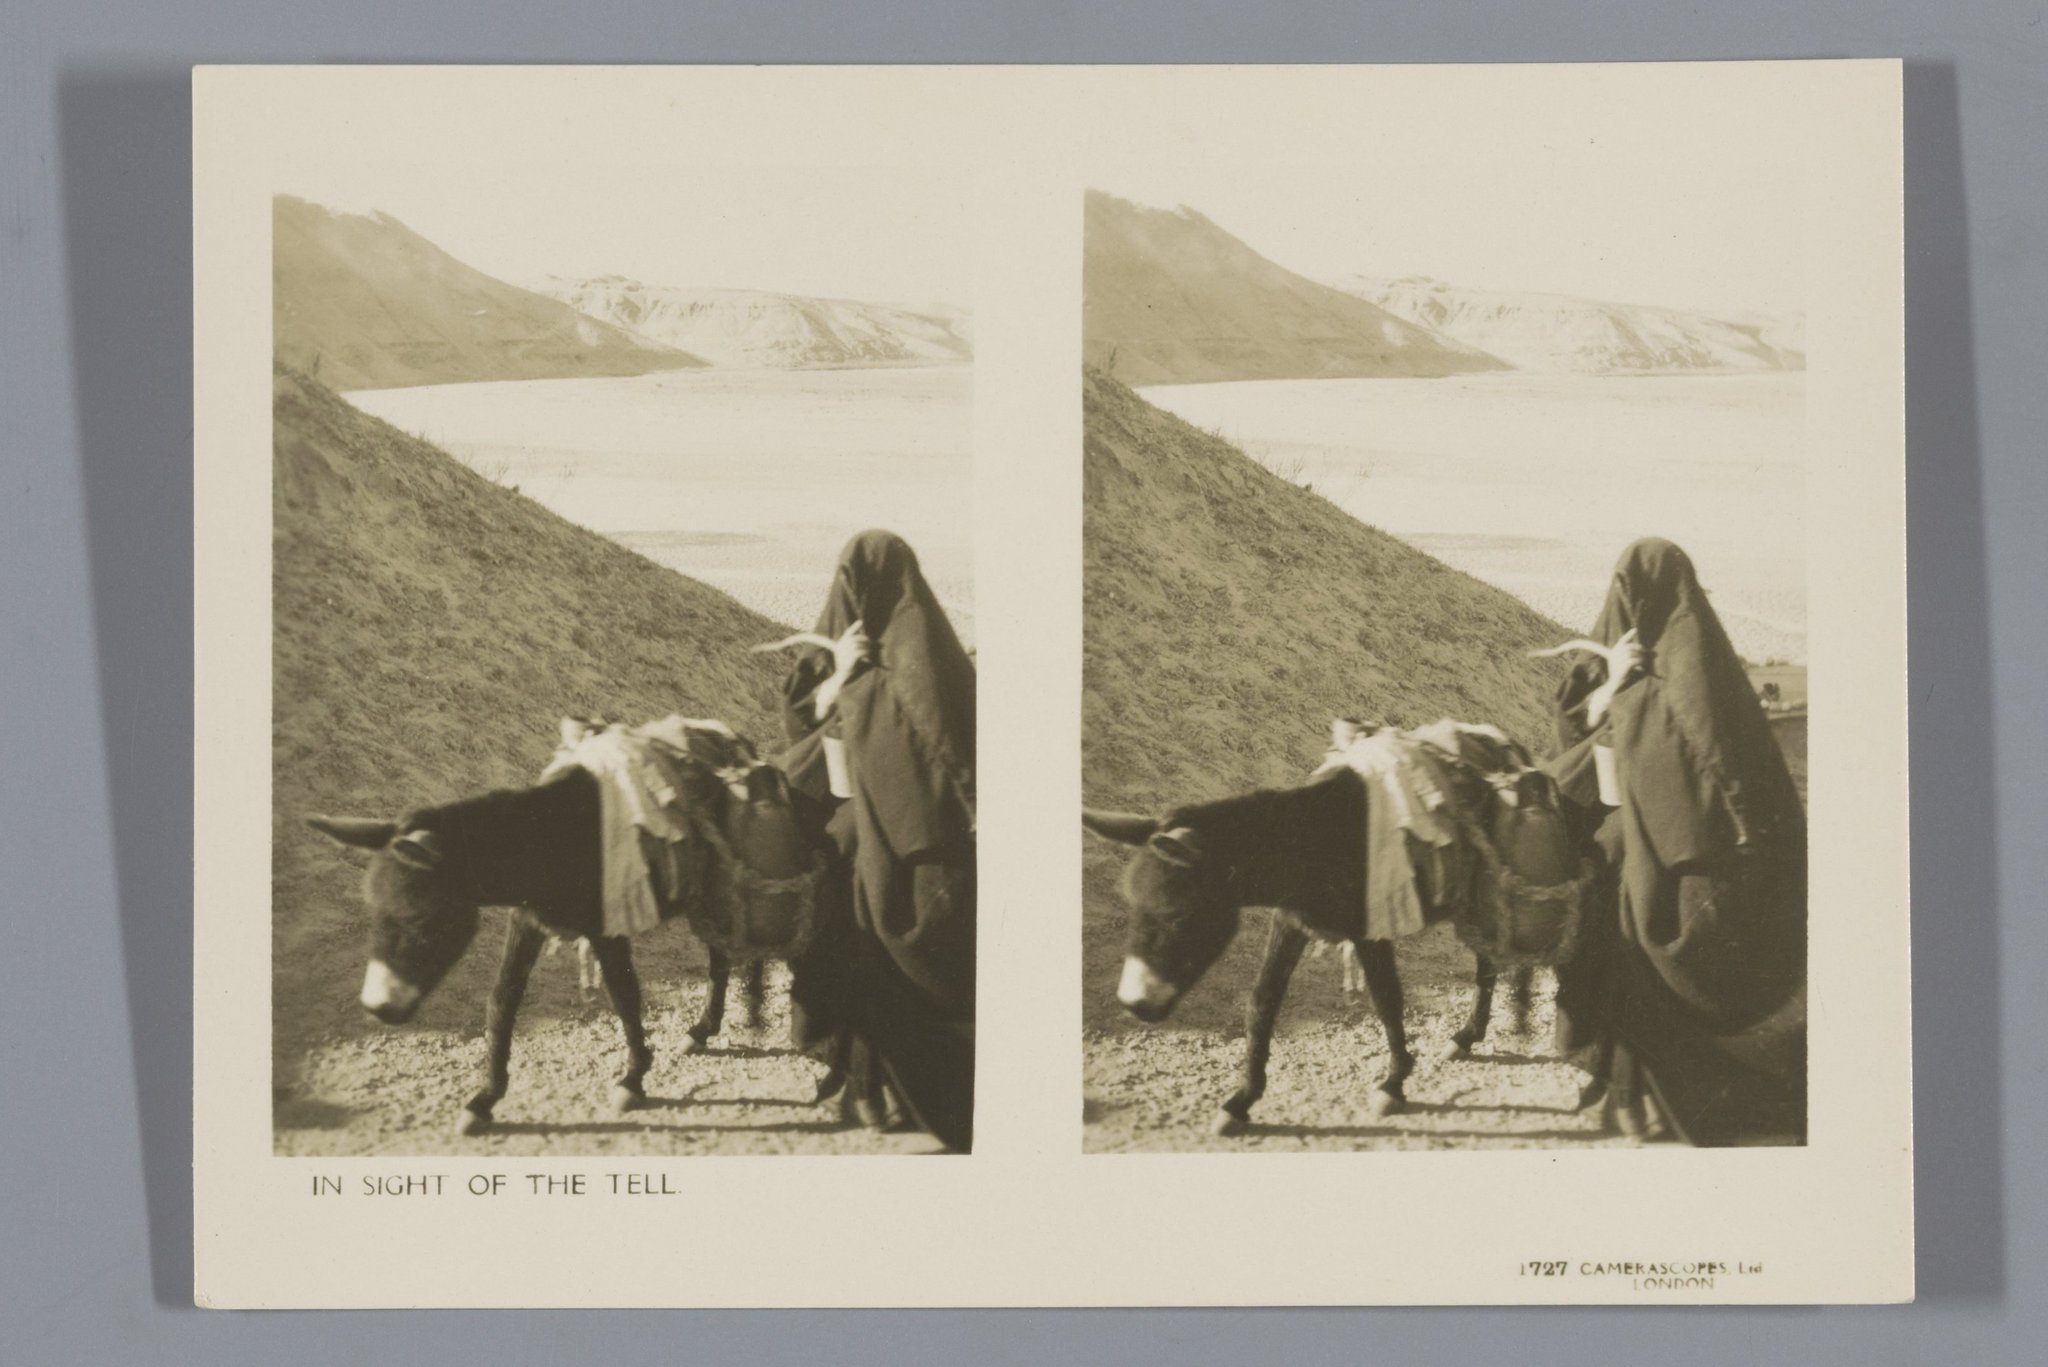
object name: stereograph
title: 6 "Picturescope" Views of Palestine Excavations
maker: richard st. barbe baker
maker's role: activist, bioloog, botanicus, fotograaf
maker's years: 1889-1982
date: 1902-1929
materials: paper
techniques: gelatin silver print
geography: london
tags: pack-animal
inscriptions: number: ‘1727’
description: Serie over de opgravingen van de Britse archeologen Gerald Harding en Flinders Petrie bij Tell Fara in het toenmalige Brits Mandaatgebied Palestina.